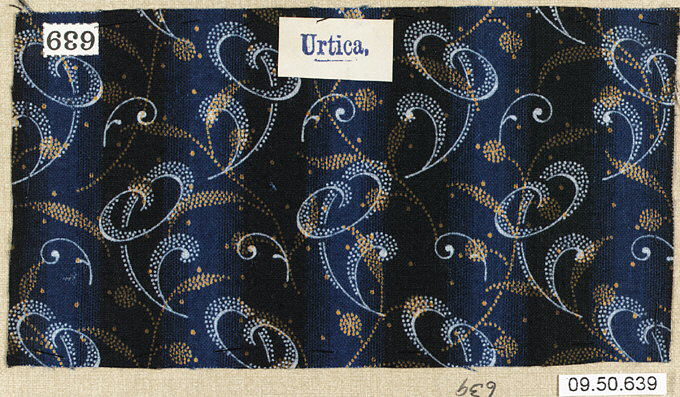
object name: piece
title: Pieces (2)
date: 1801-1900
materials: cotton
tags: flowers,leaves